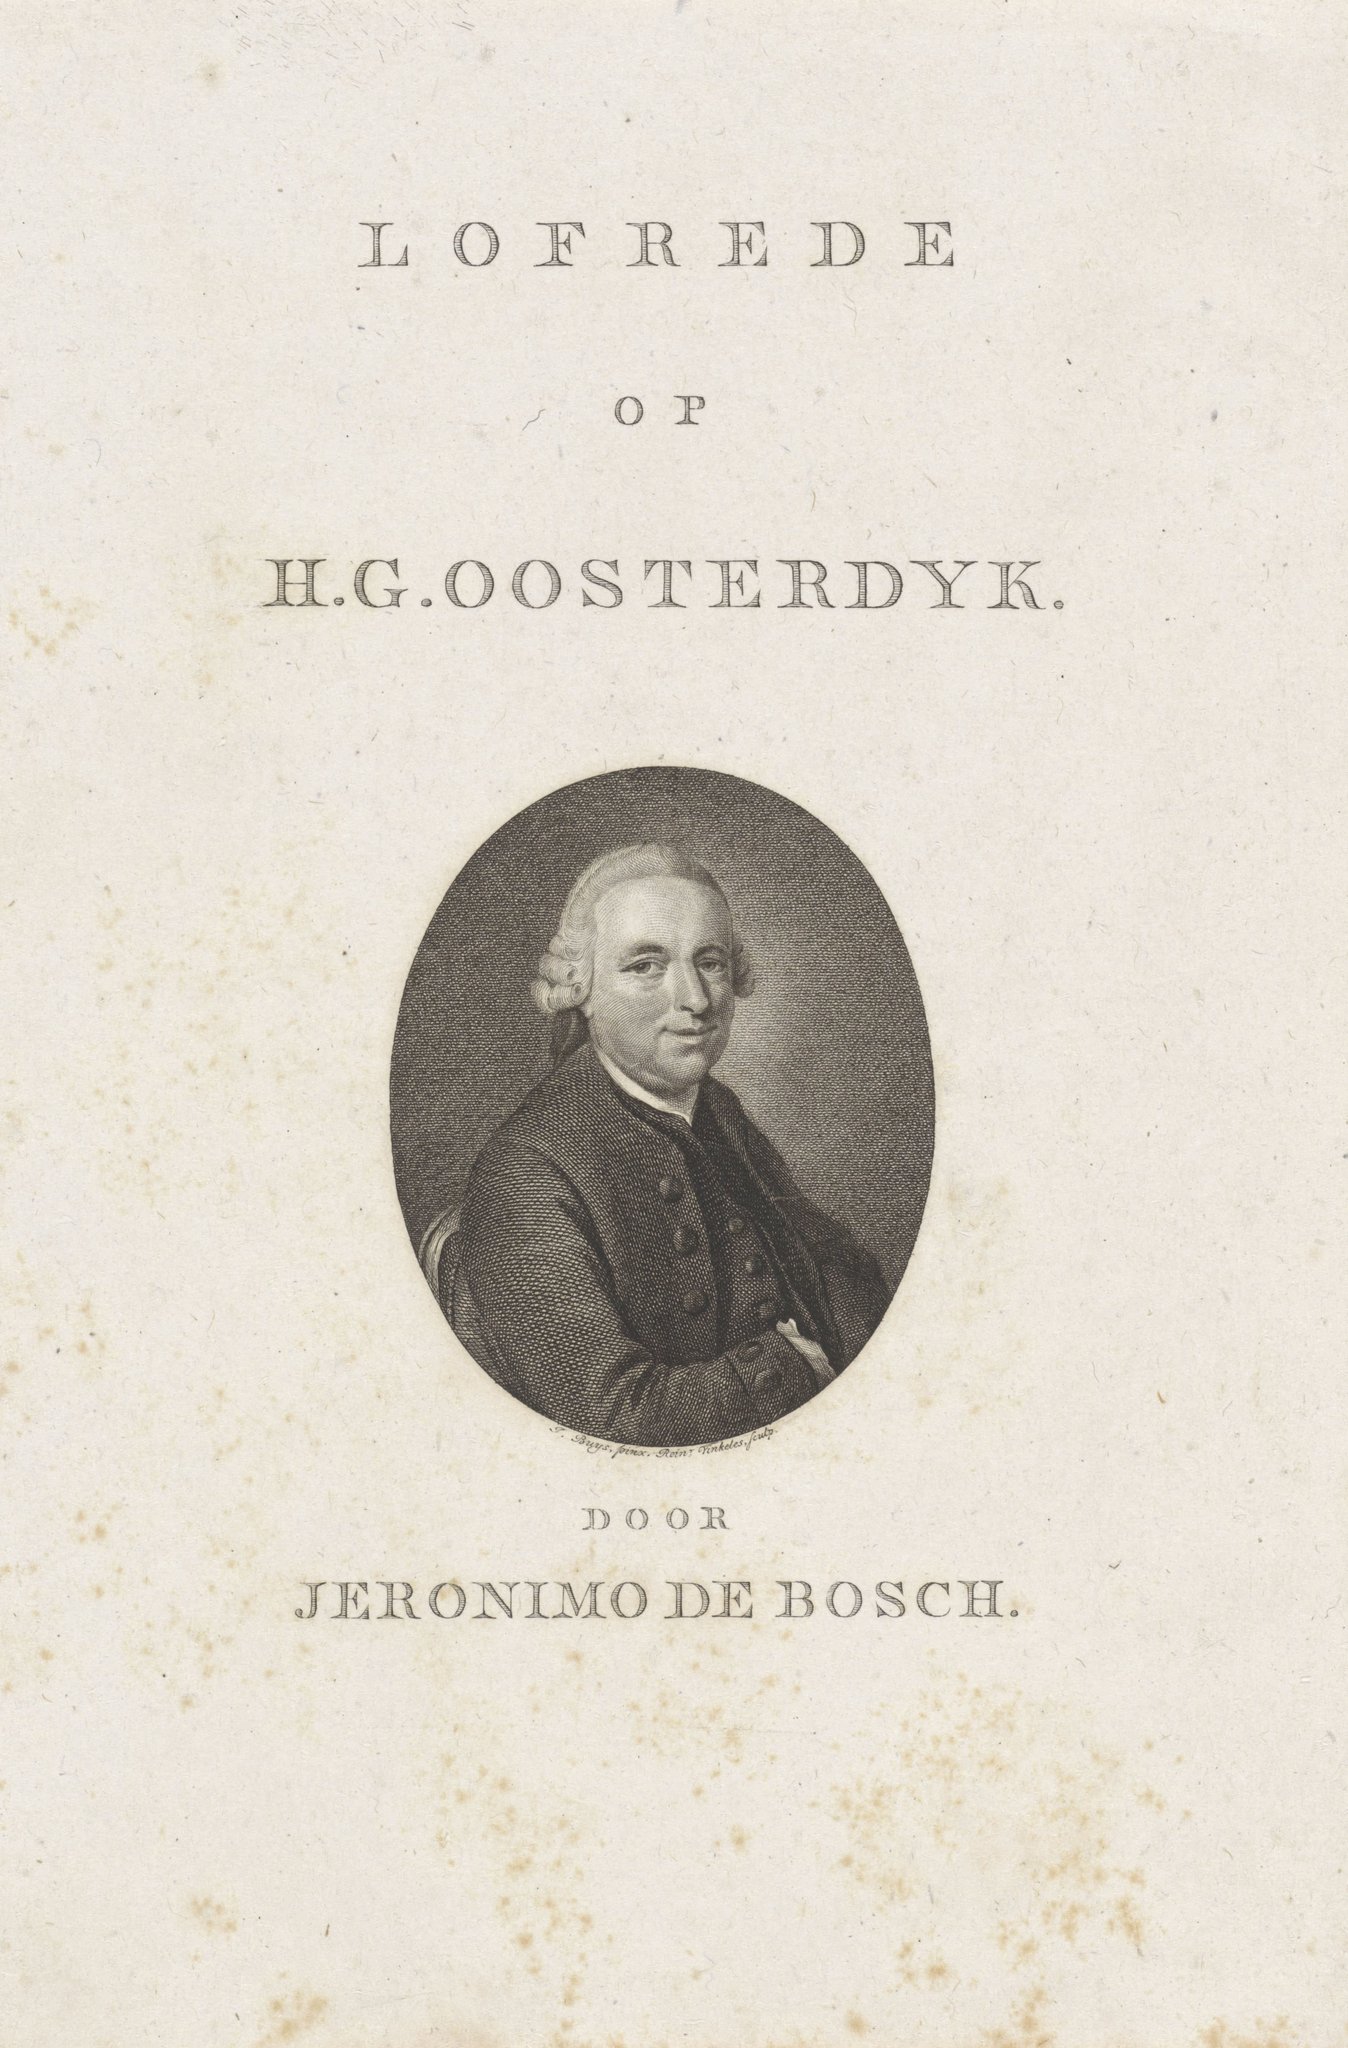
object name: titelblad, titelpagina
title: Titelpagina voor: J. de Bosch, Lofrede op H.G. Oosterdyk, 1795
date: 1795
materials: paper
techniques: engraving, etching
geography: amsterdam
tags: katwijk aan den rijn, dichter, hermannus gerardus oosterdijk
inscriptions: collector's mark: Lugt 240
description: Titelpagina voor: Bosch, Jeronimo de. Lofrede op H. G. Oosterdyk. Amsterdam: Petrus den Hengst, 1795.